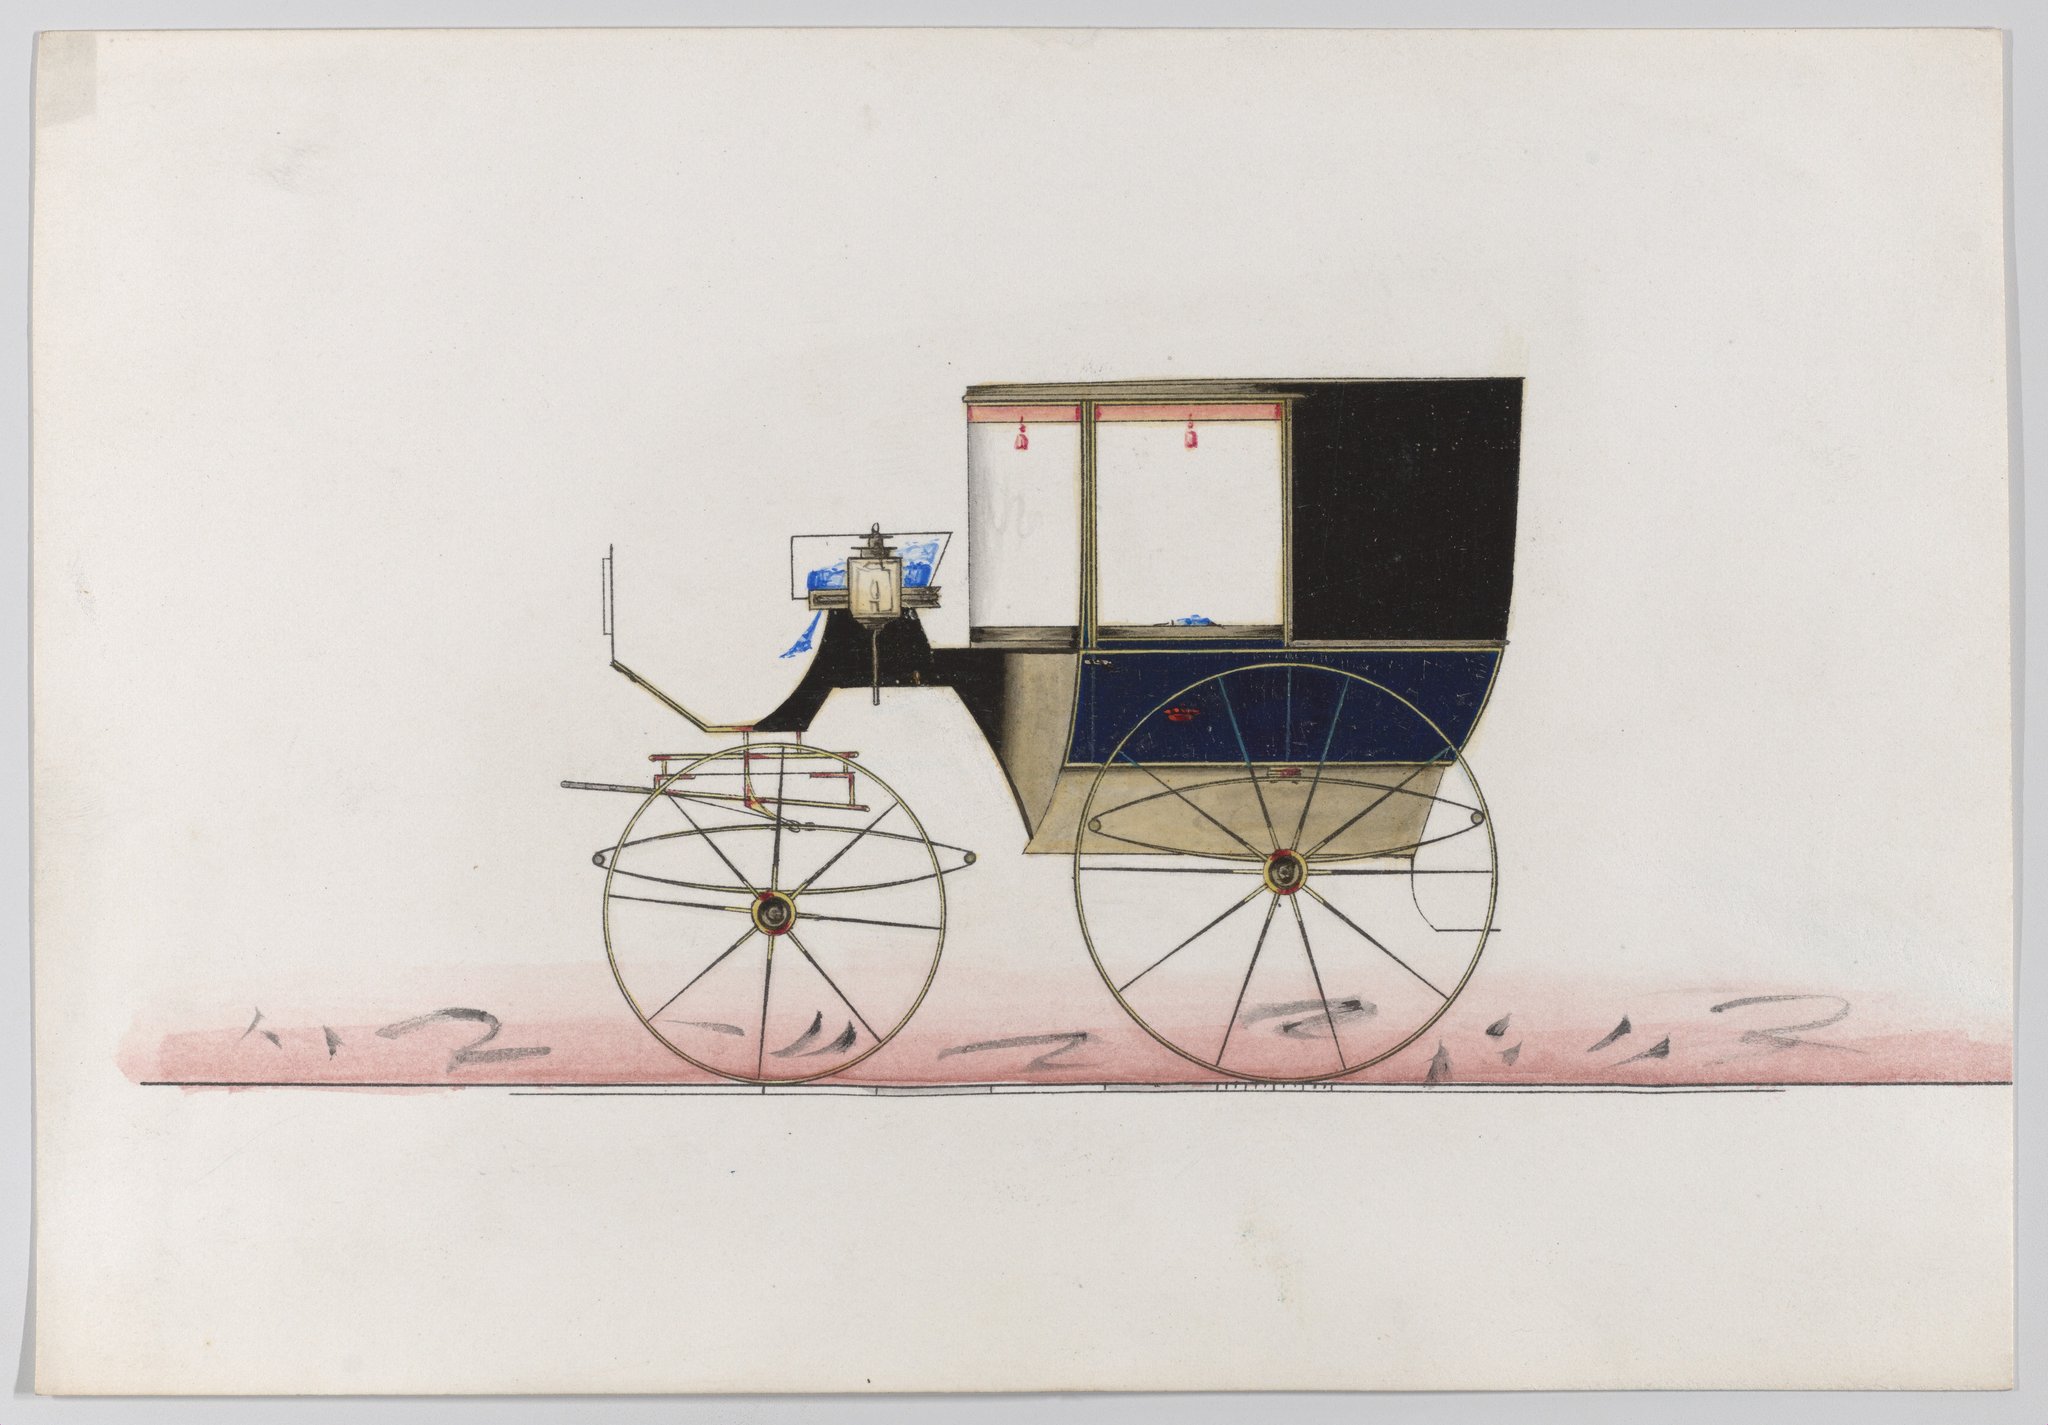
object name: drawing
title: Design for Double Brougham (unnumbered)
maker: brewster & co.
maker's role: manufacturer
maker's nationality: american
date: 1870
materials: gouache, gum arabic, ink, watercolor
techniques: pen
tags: carriages